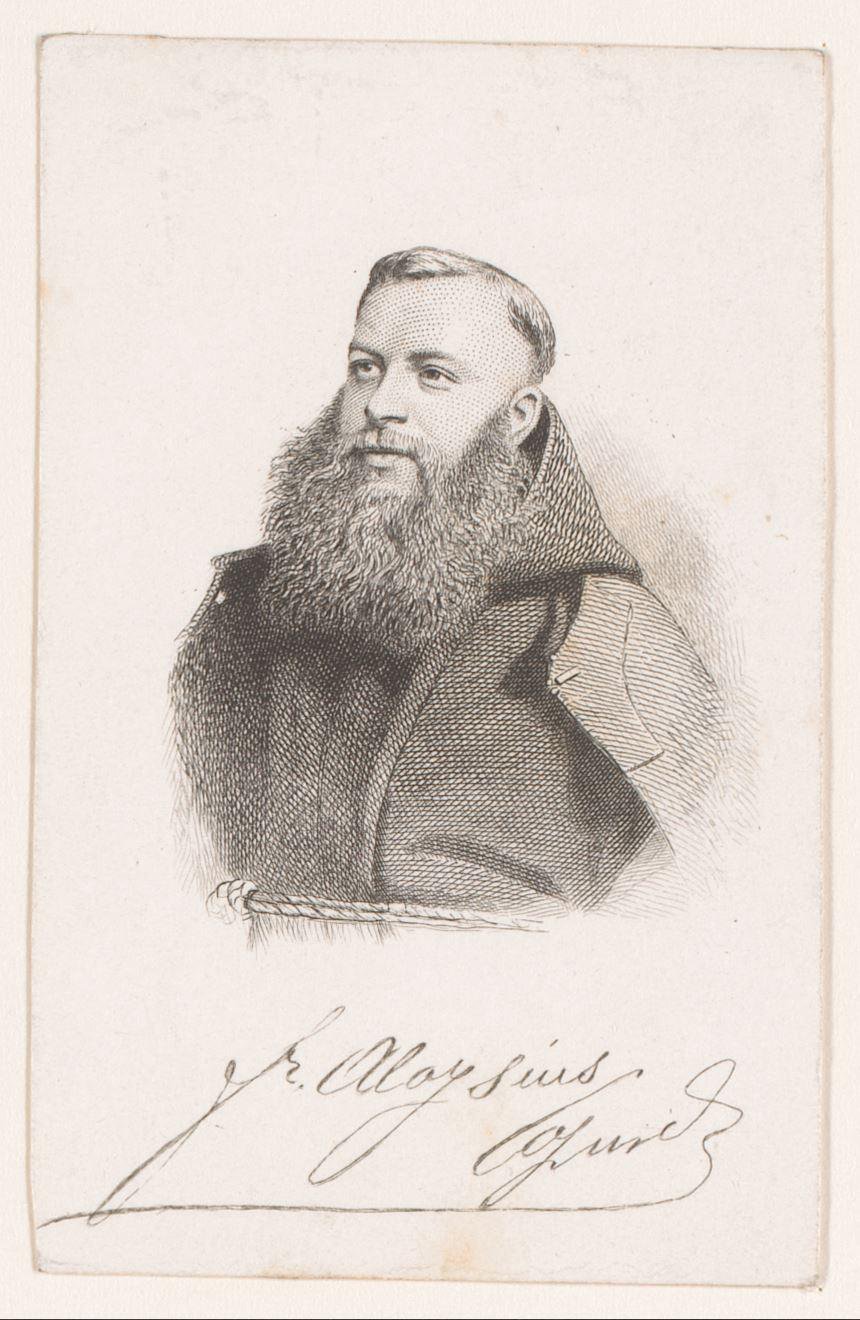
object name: print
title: Portret van een onbekende man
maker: jean baptiste pierre michiels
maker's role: print maker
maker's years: 1821-1890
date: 1831-1890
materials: paper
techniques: etching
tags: adult man, historical persons, monk(s), friar(s)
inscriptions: inscription: Lugt 2228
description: Deze prent is onderdeel van een grotere plaat met meerdere portretten (zie RP-P-1913-1858).